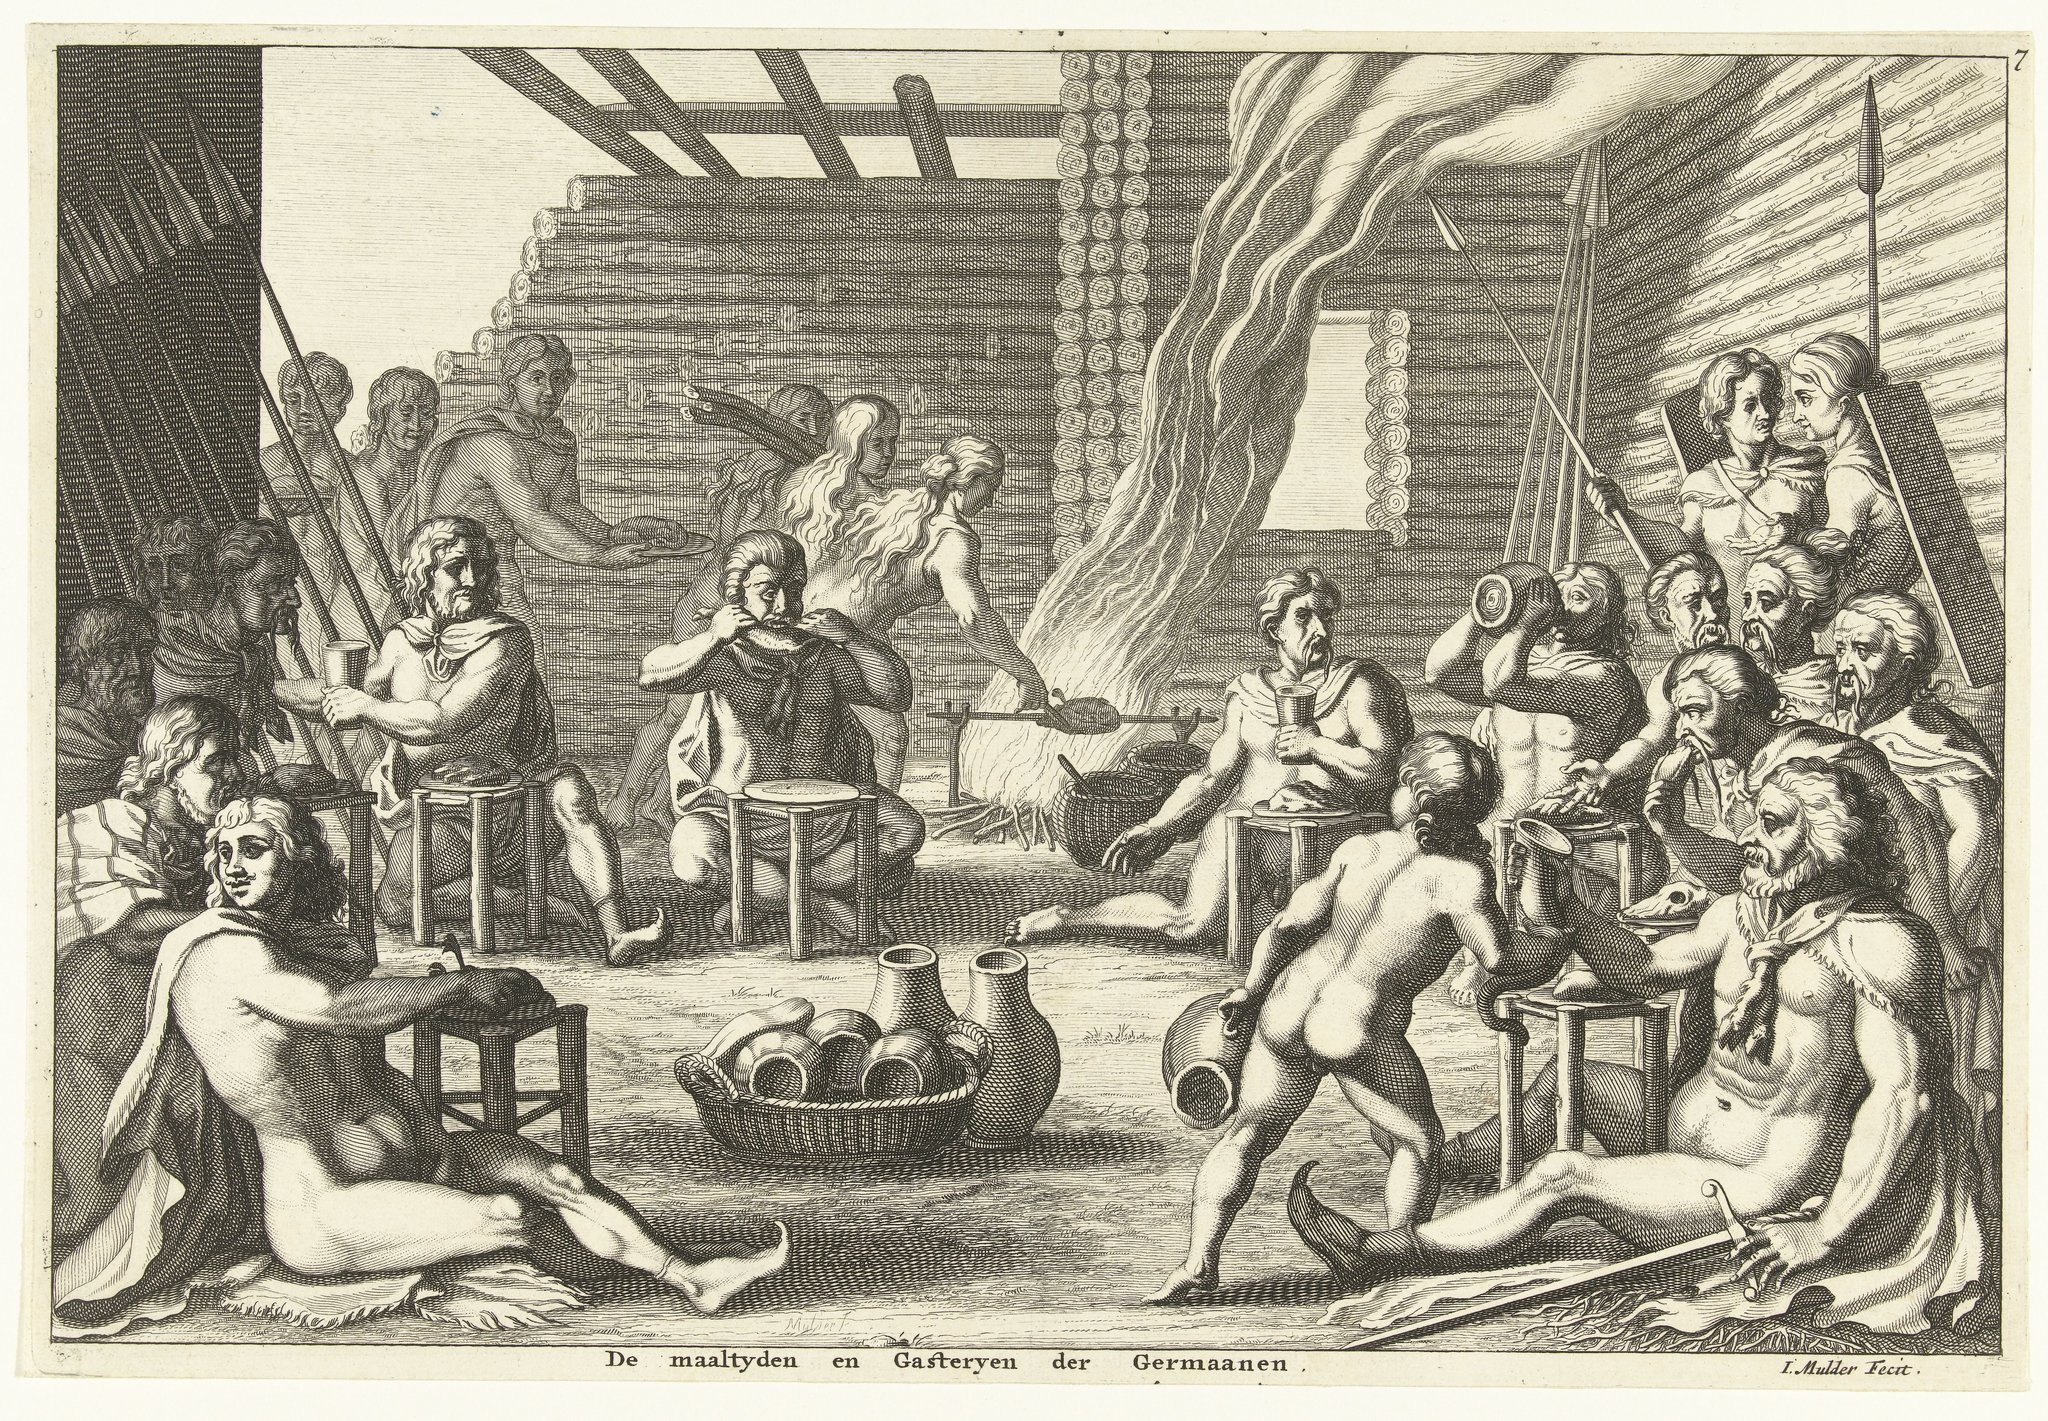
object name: print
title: Maaltijd en gastvrijheid bij de Germanen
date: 1684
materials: paper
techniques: engraving, etching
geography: amsterdam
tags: (family) meal, extinct, 'historical' peoples (with name)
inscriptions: collector's mark: Lugt 2228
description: Prent uit: Tacitus, Cornelius. Jaarboeken en Historien (...). [Vertaald uit het Latijn door] Pieter Corneliszoon Hooft. Amsterdam: Jacob de Jonge (wed.), Dirk Boom (wed.) en Hendrick Boom, 1684.